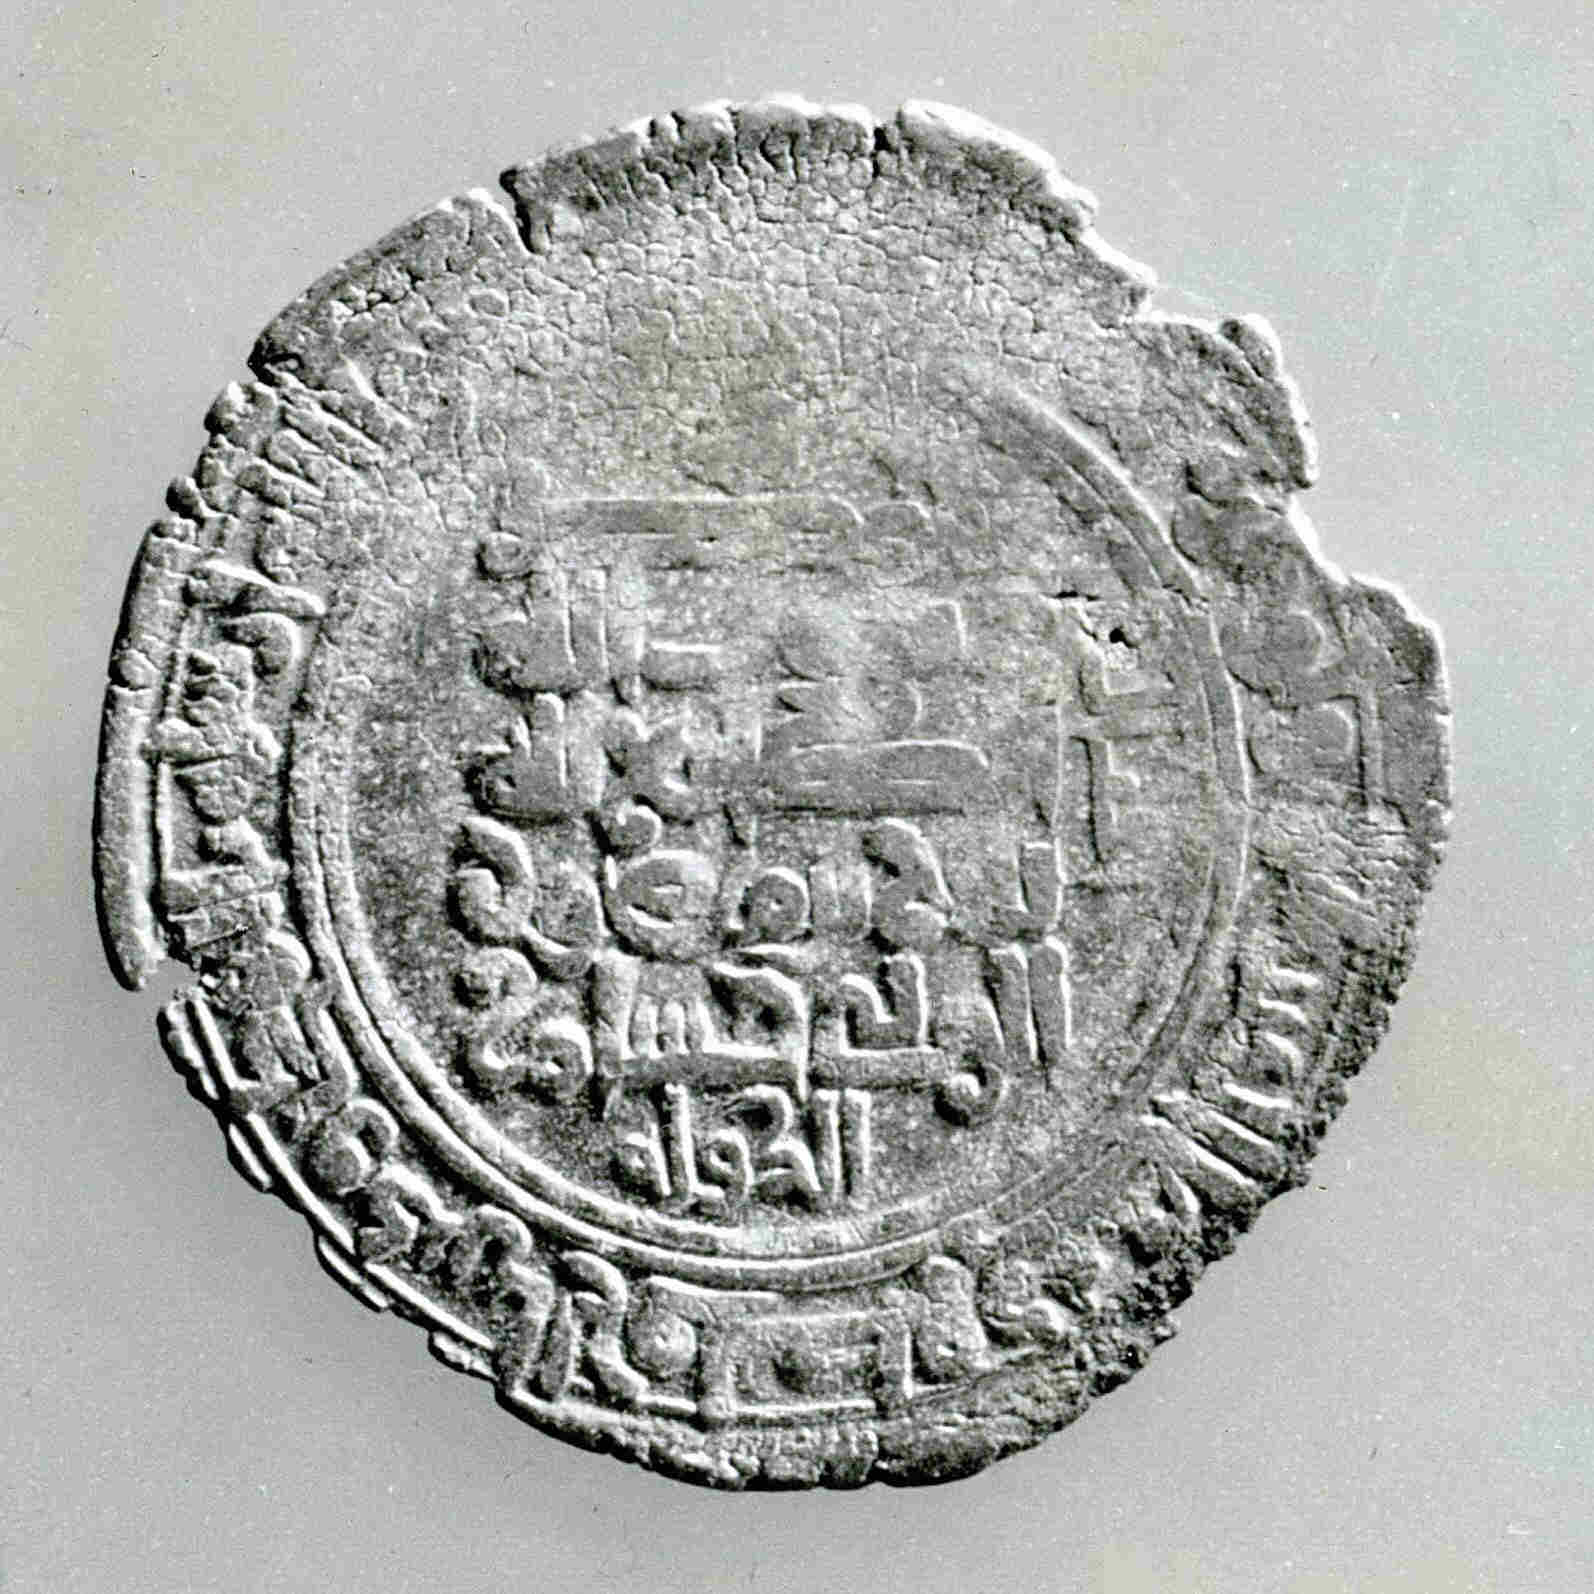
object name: coin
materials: silver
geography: iran